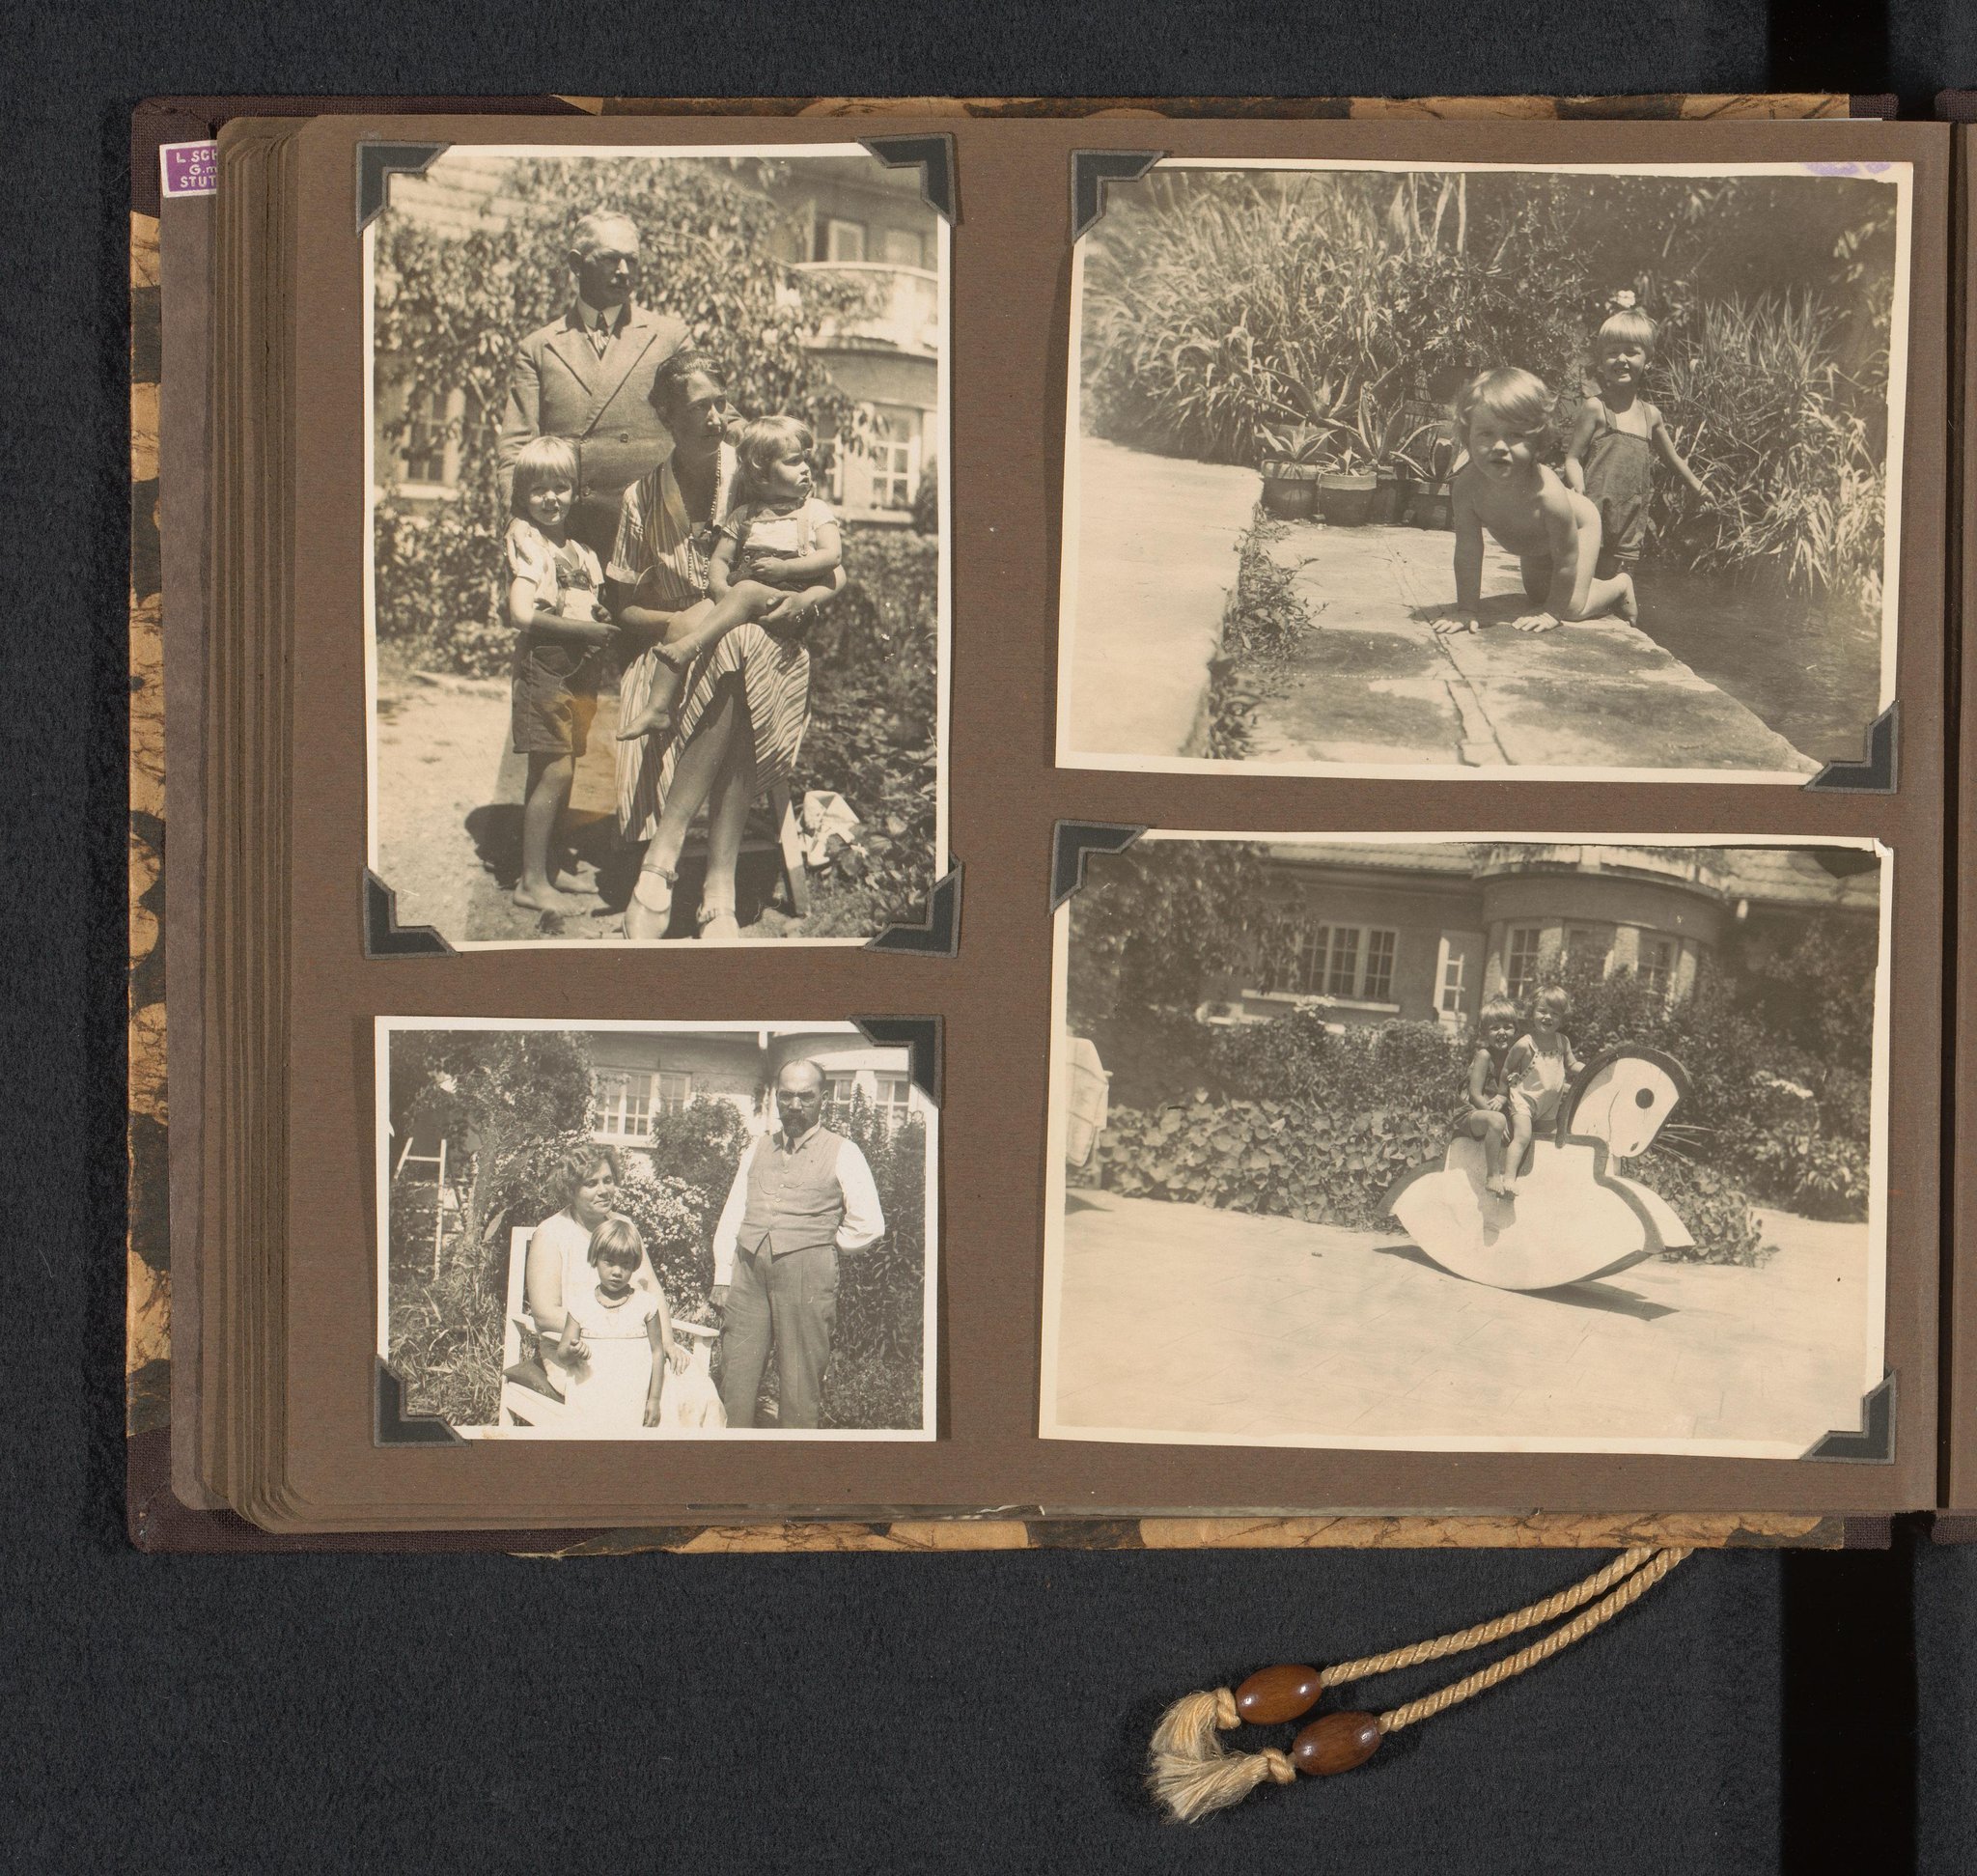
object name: album leaf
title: Onbekend gezin, mogelijk tijdens rondreis van Eugen Wachenheimer en Else Wachenheimer-Moos door Bulgarije, 1926-1927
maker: else wachenheimer-moos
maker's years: 1895-1944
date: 1926-1927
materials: paper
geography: bulgaria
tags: bulgarije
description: Albumblad bevat vier foto's van onbekende personen. Afkomstig uit album half formaat, kartonomslag met koordbinding en lichte veelvormige vormen op voorzijde.